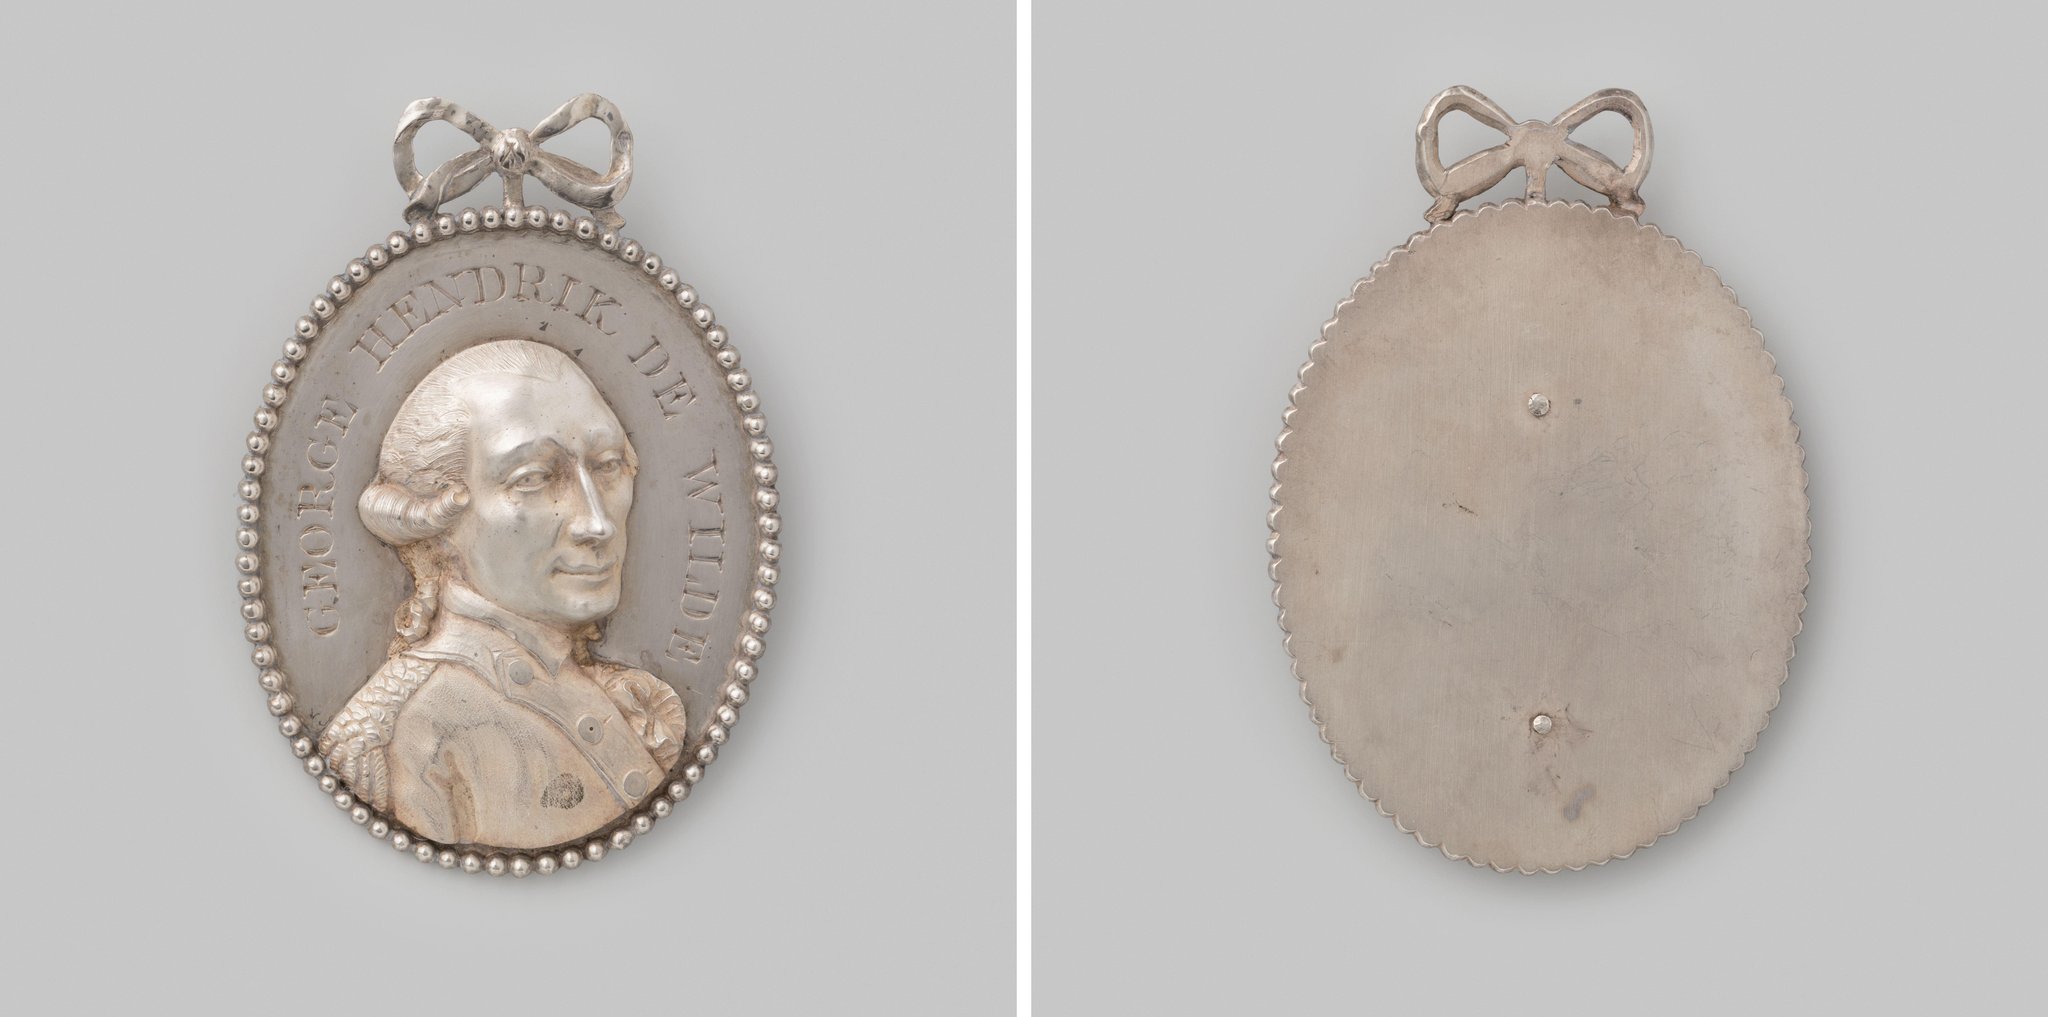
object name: insignia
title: George Hendrik de Wilde, luitenant-kolonel van de schutterij te Amsterdam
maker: Anonymous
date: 1787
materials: silver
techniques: casting, embroidery, fastening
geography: netherlands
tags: amsterdam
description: Eenzijdig zilveren ovaal draagteken met parelrand en opengewerkte strik. Voorzijde: borststuk man binnen omschrift. Keerzijde: blanco; op keerzijde zijn nog twee nagels zichtbaar, waarmee voor- en keerzijde aan elkaar zijn bevestigd